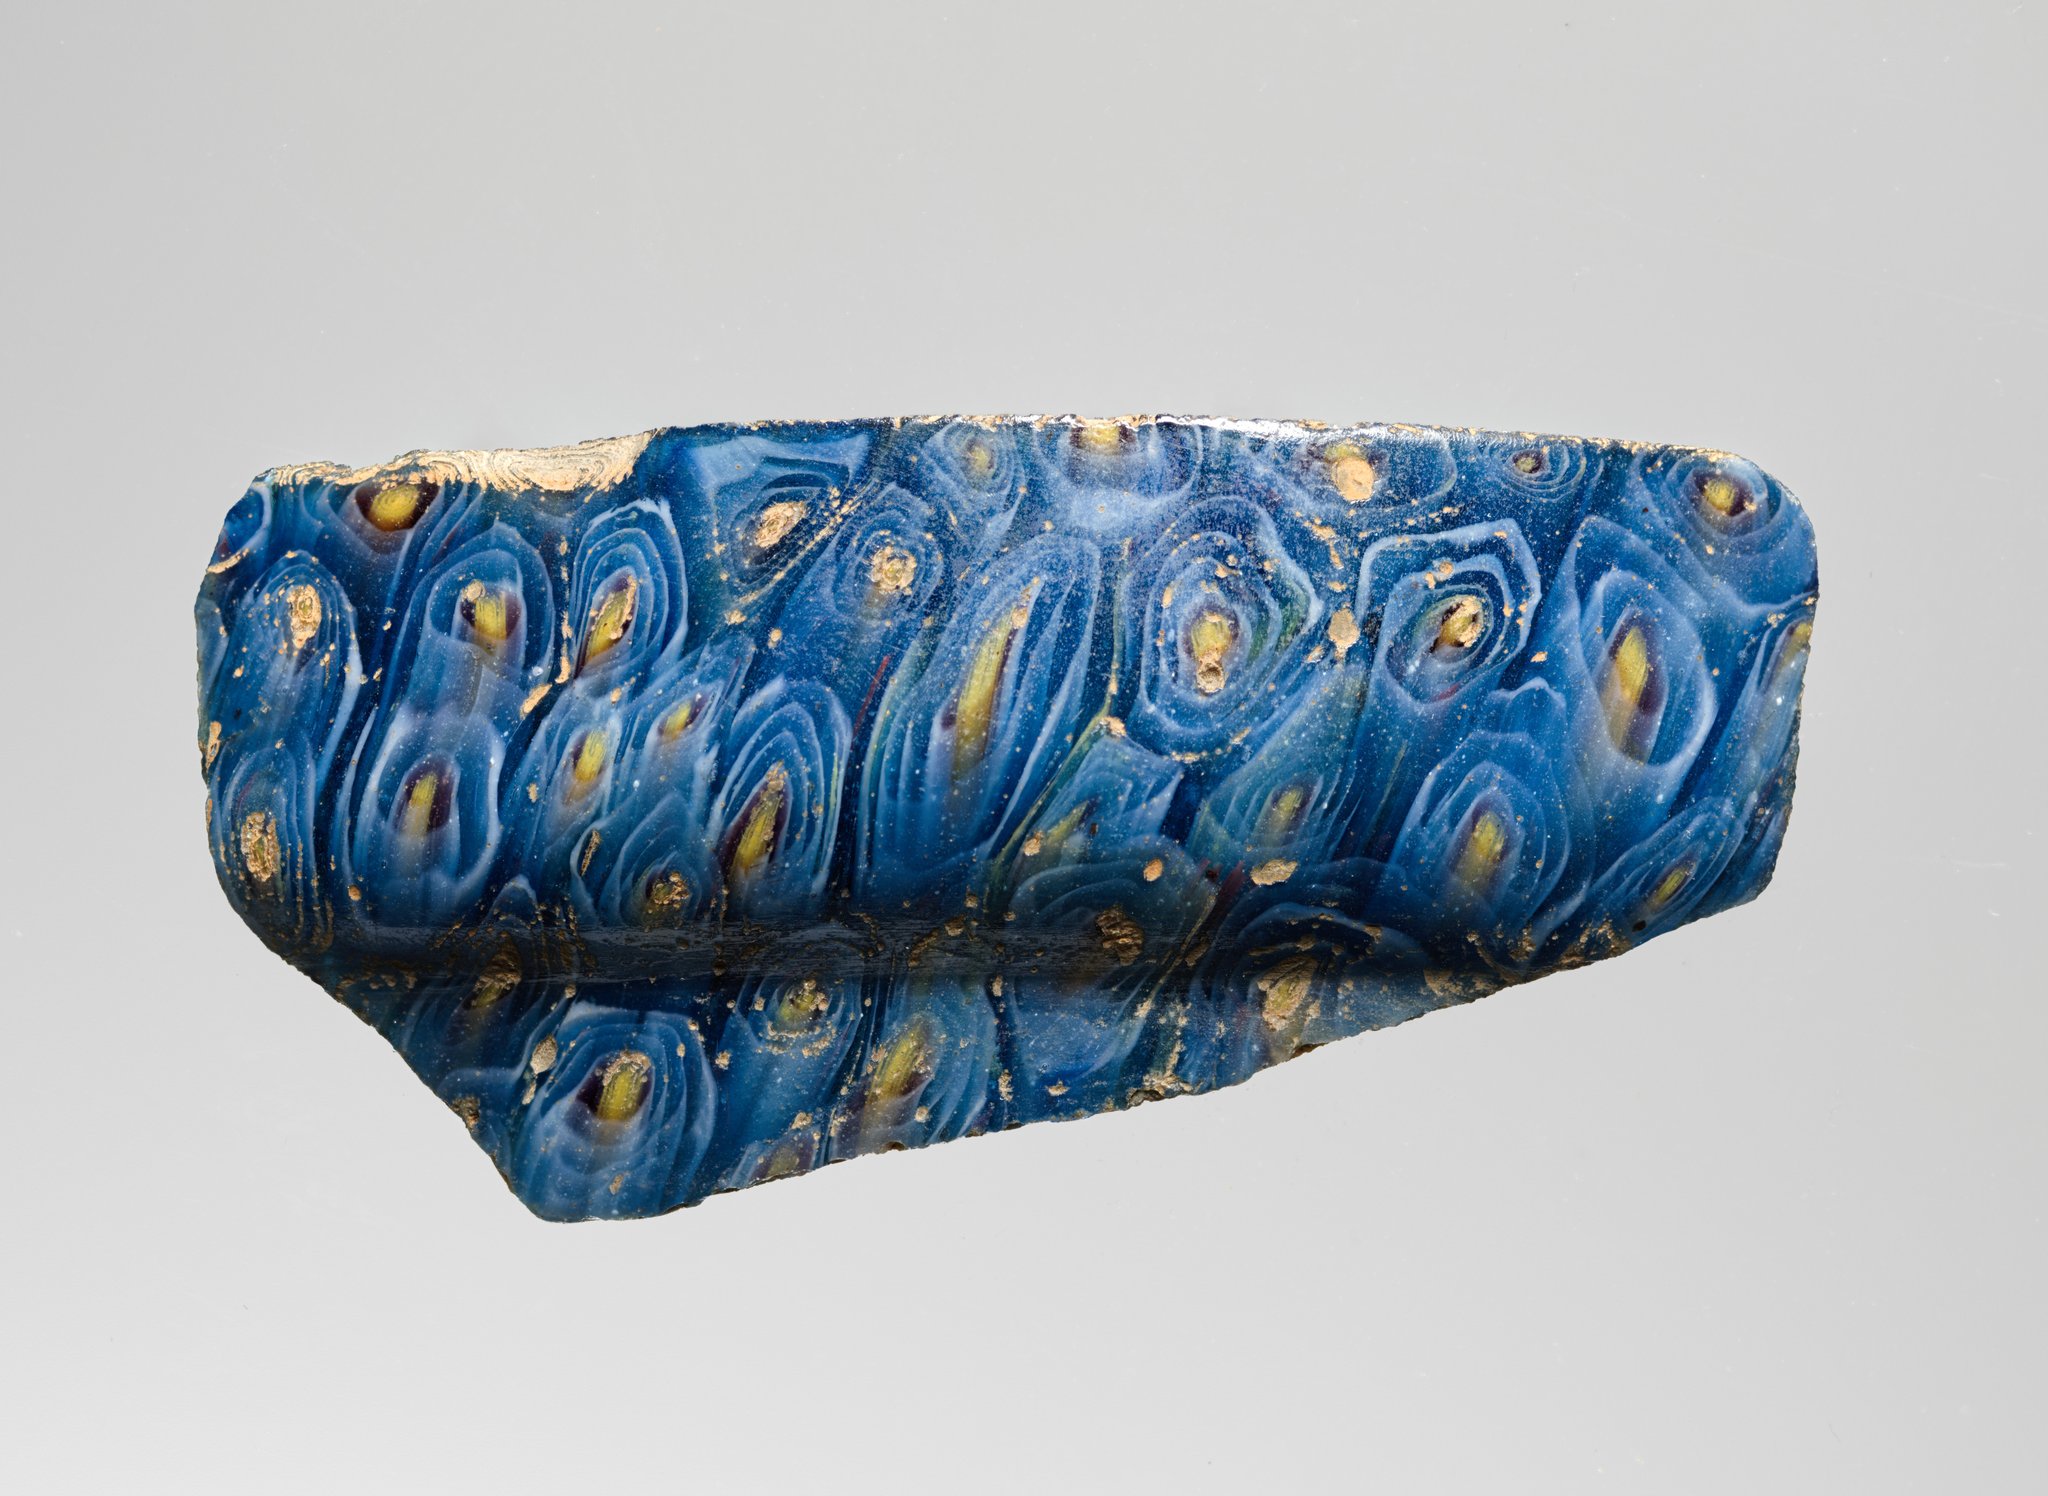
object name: fragment, mosaic bowl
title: Glass mosaic carinated dish fragment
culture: roman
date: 34 BCE-33 CE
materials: glass